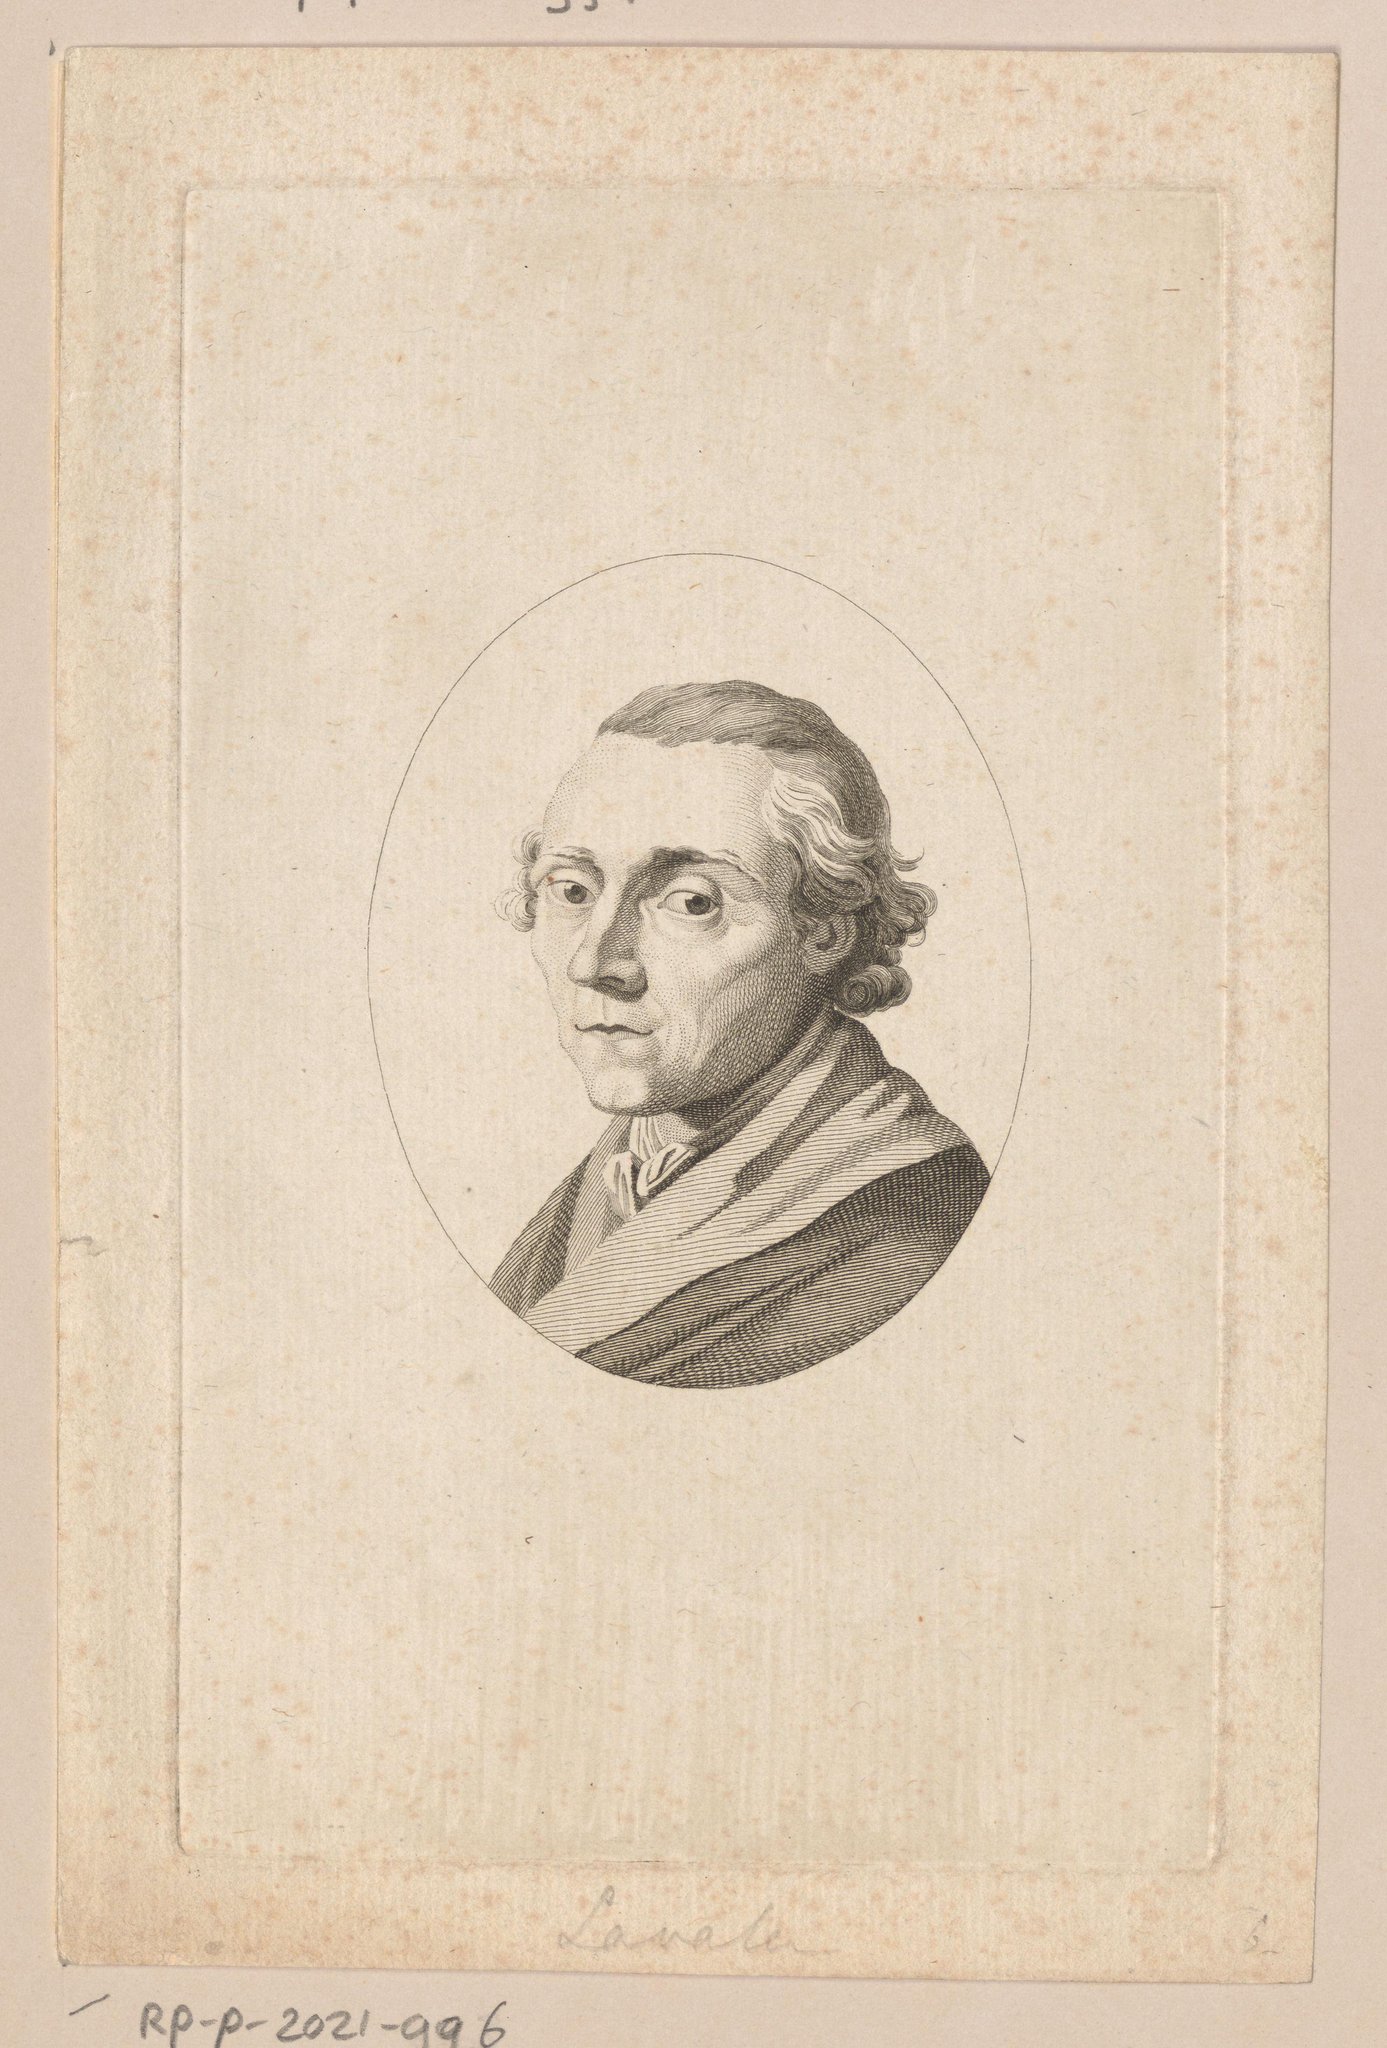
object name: print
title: Portret van Johann Caspar Lavater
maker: Anonymous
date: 1775-1820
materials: paper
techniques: etching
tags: johann caspar lavater, historical persons, scholar, philosopher (+ portrait of scholar, scientist)